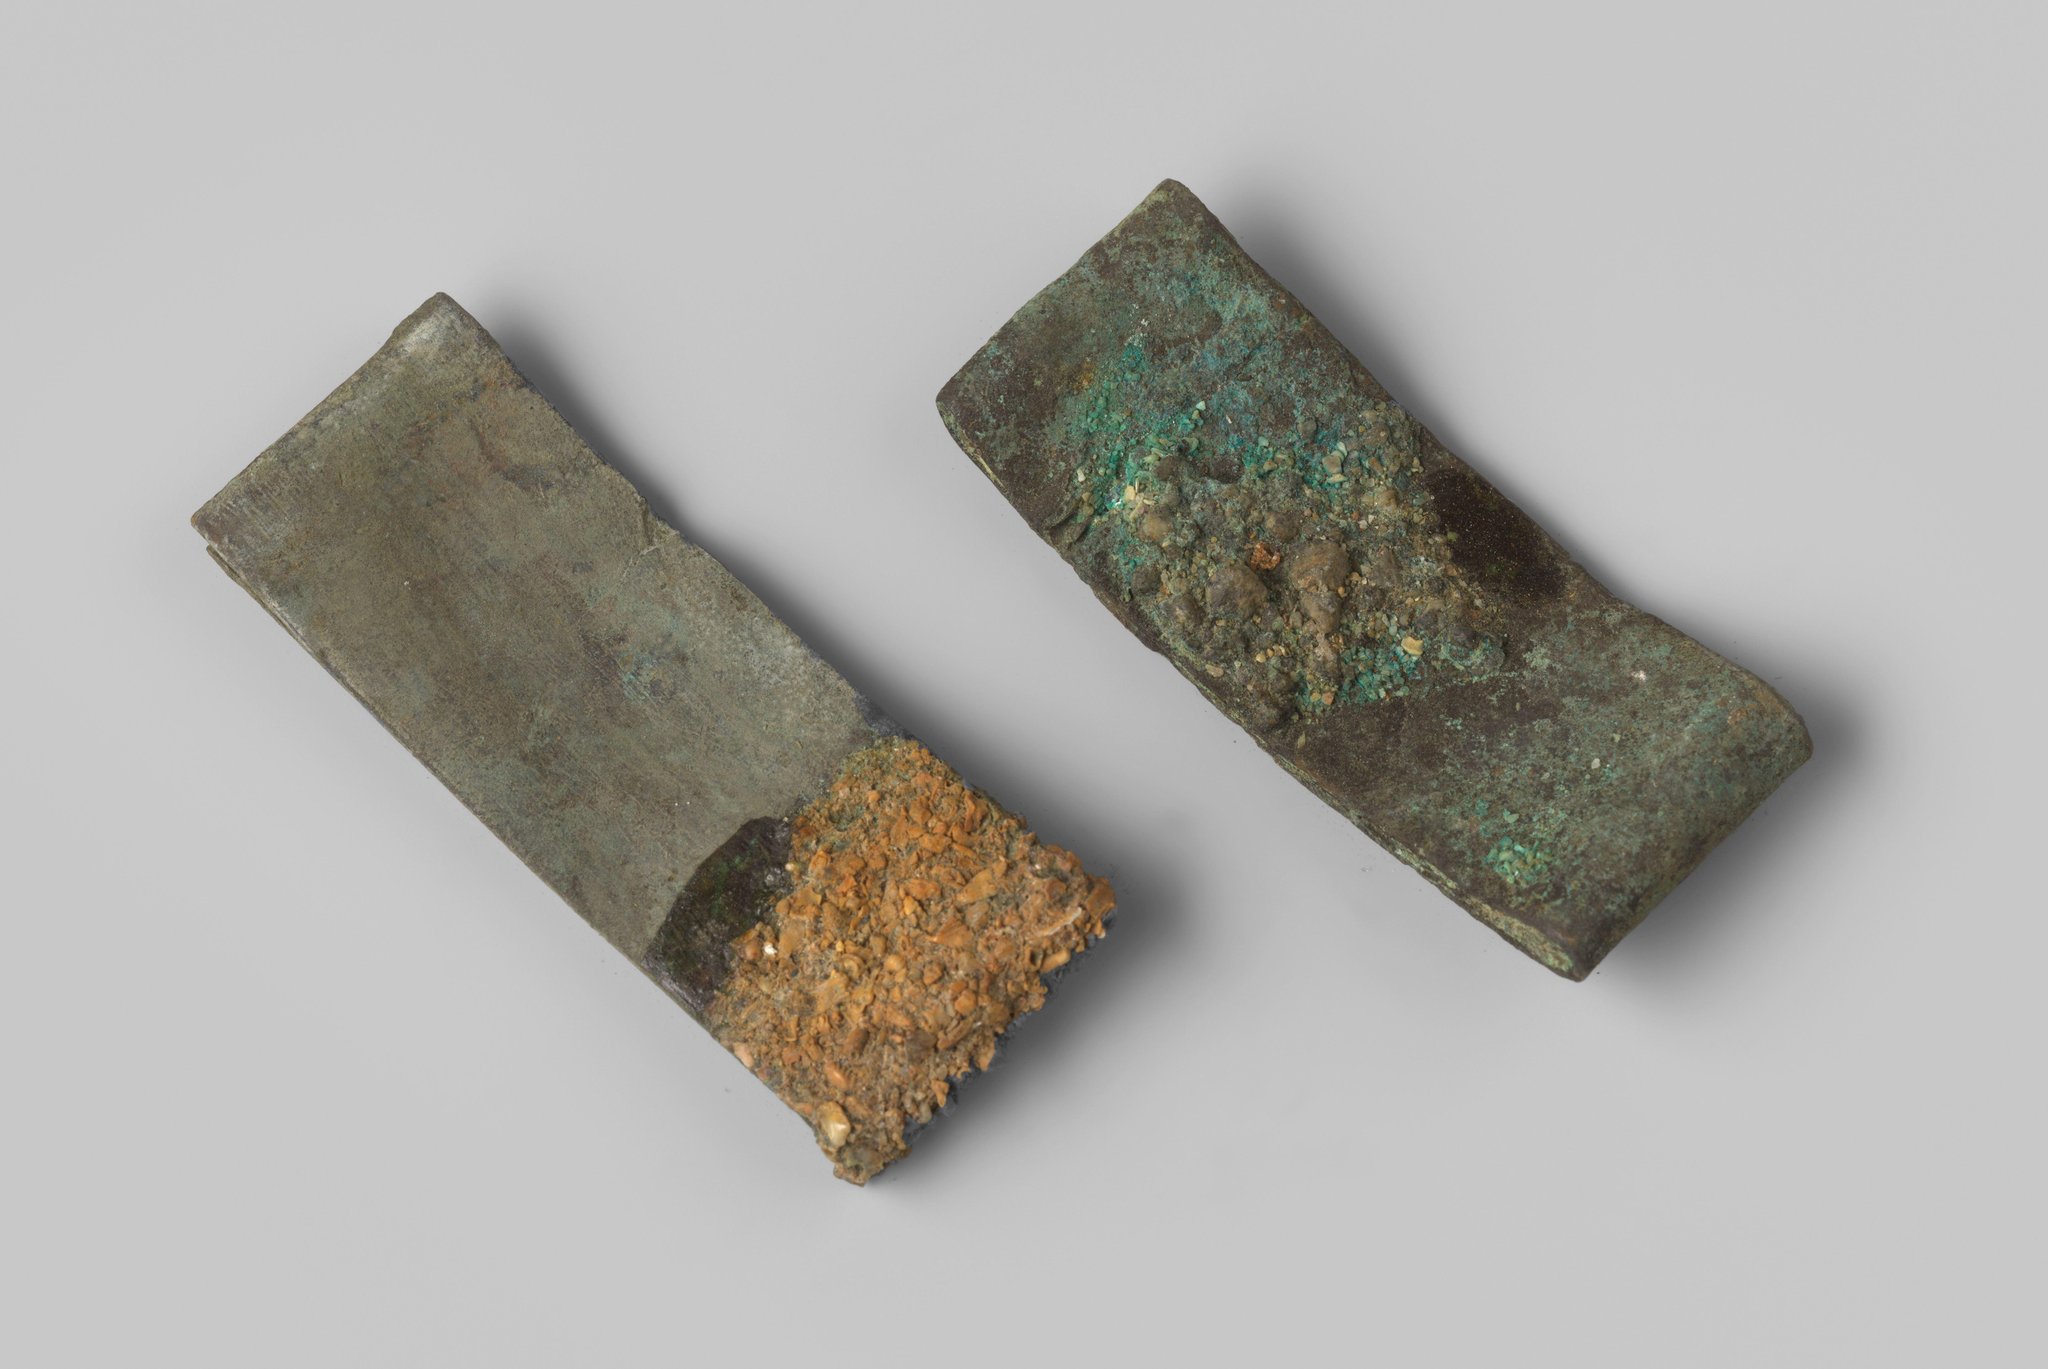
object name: firehose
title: Brandslangringen uit het wrak van de Oost-Indiëvaarder Hollandia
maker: Anonymous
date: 1700-1743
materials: copper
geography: netherlands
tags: verenigde oostindische compagnie, hollandia (schip), annet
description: Fire engine, firehose; fragm, id. NG 1975-20H1271a, squashed.